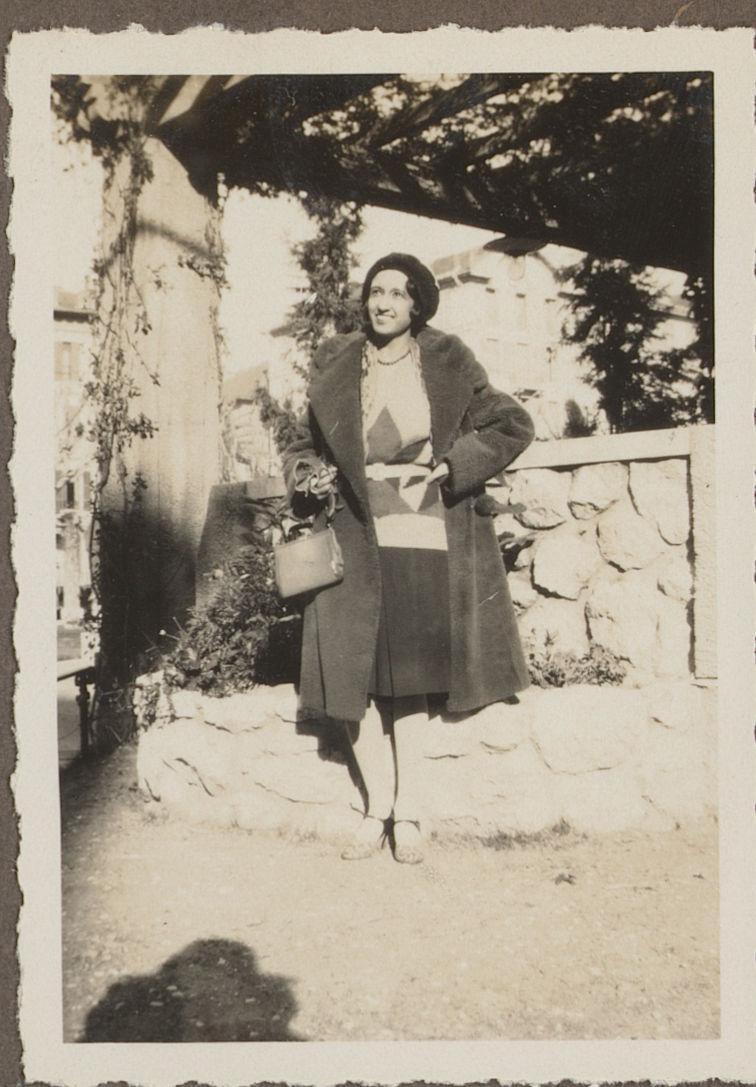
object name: photograph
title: Dootje van Zijll de Jong met open jas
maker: Anonymous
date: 1930-1935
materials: paper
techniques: gelatin silver print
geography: netherlands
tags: adult woman, netherlands